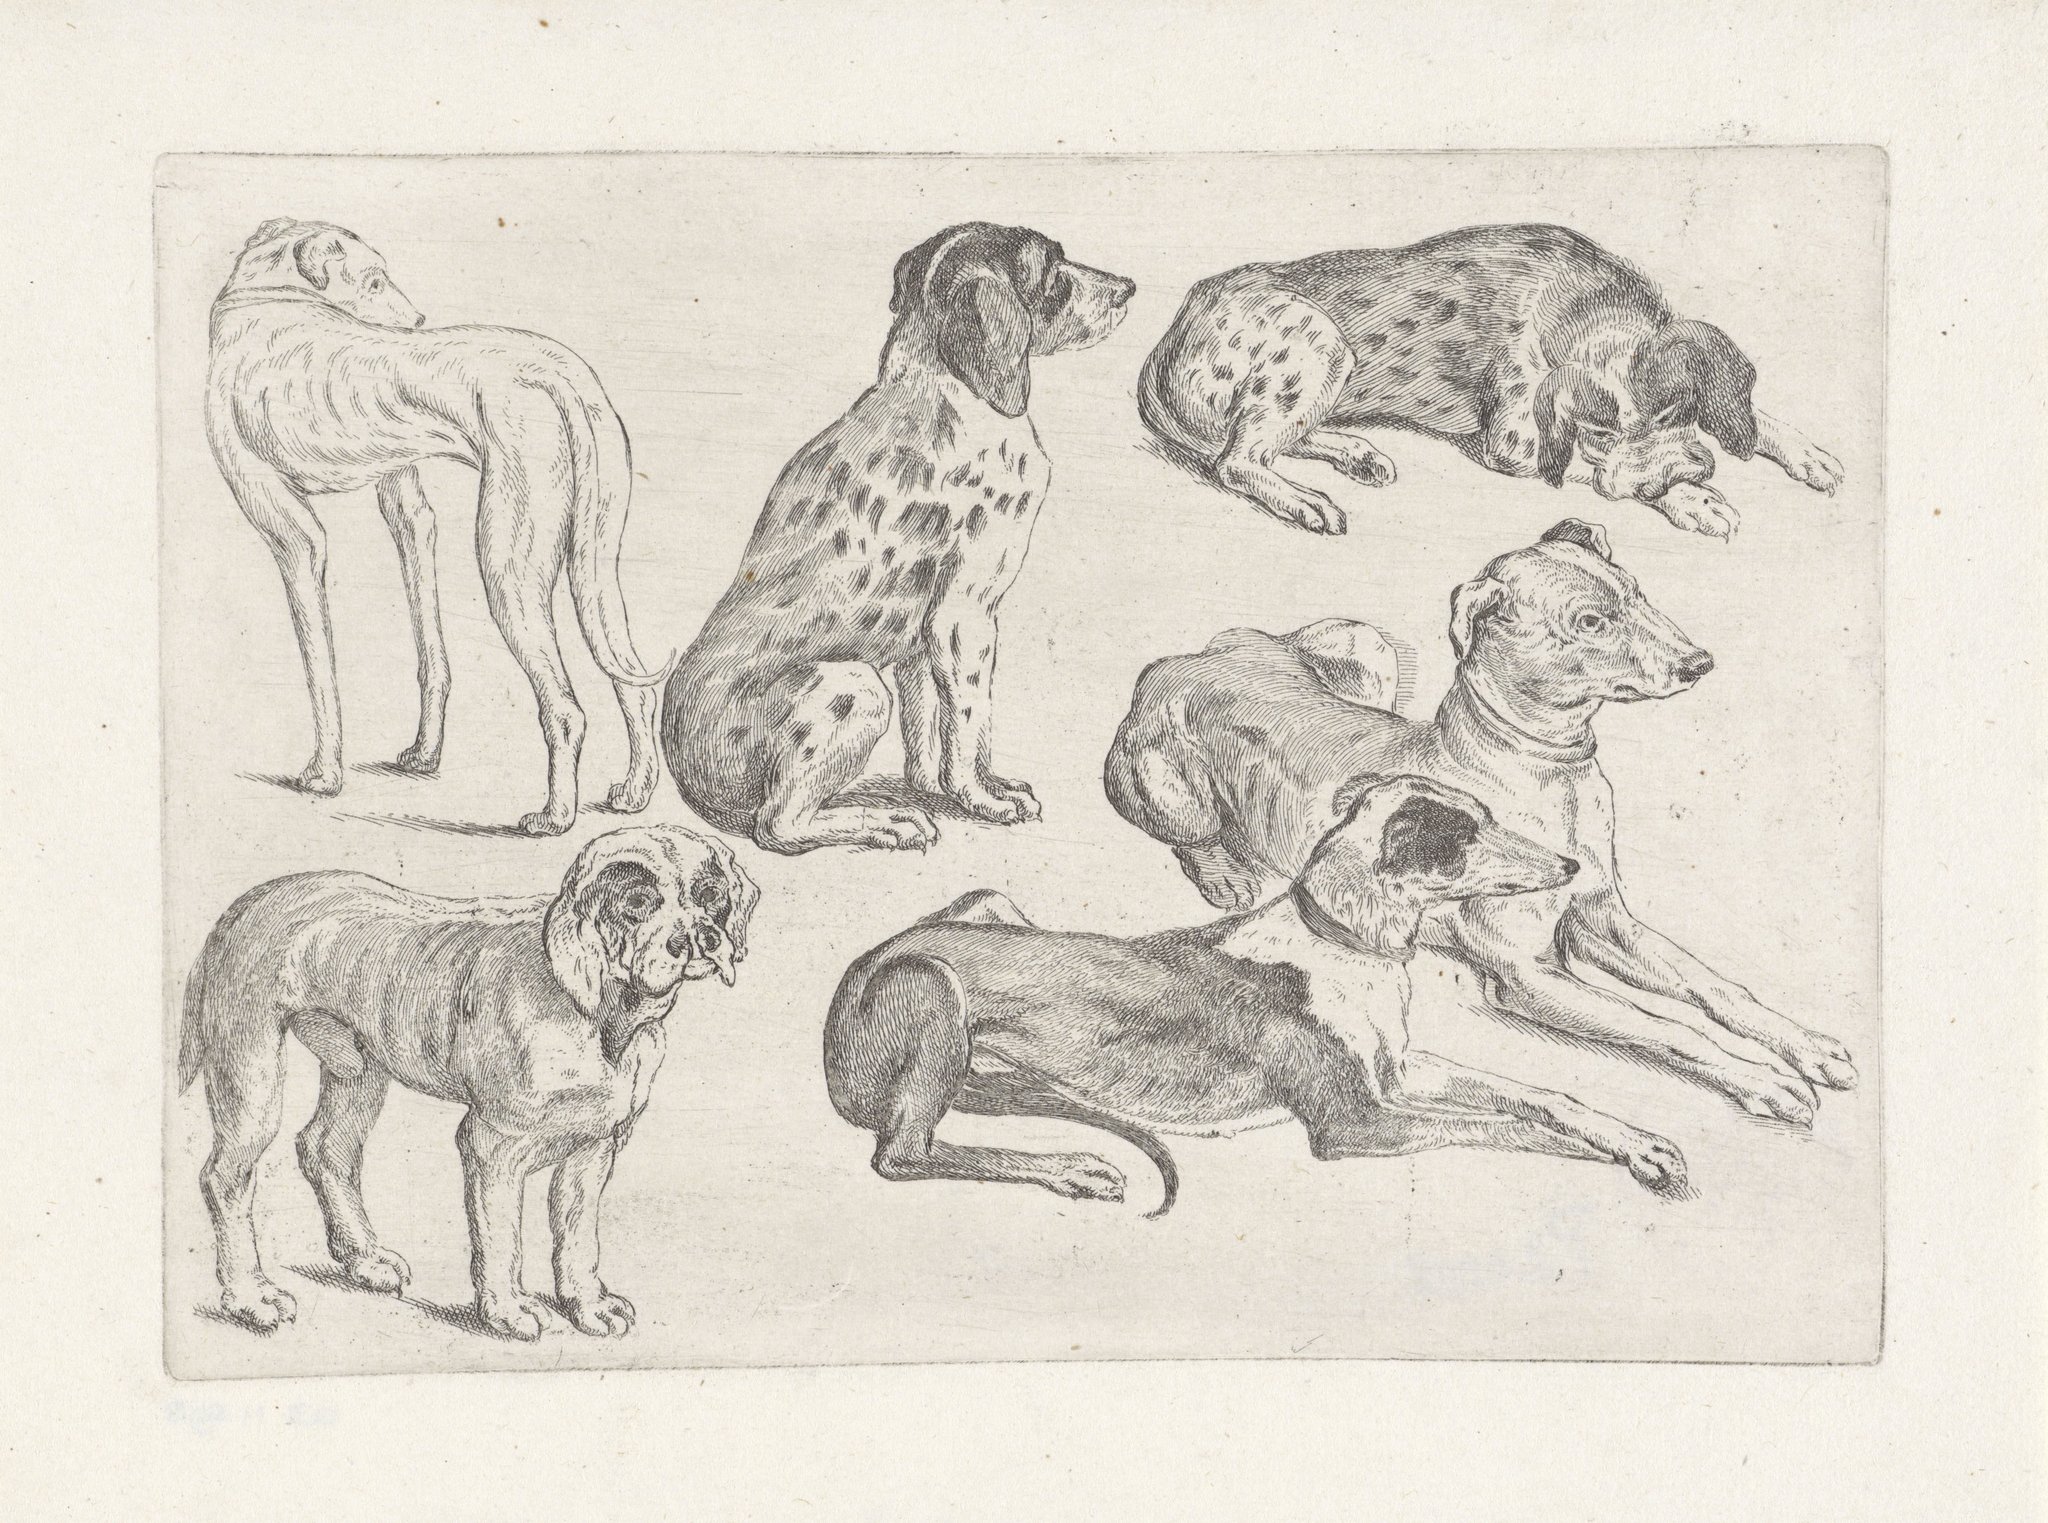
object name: print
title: Zes jachthonden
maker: wenceslaus hollar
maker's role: draughtsman, print maker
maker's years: 1607-1677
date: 1646-1647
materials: paper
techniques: etching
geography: antwerp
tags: hunting dogs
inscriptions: collector's mark: Lugt 240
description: Prent uit twintigdelige serie (incl. titelprent) met voorstellingen over de jacht: "Jacht, jachthonden en wild".